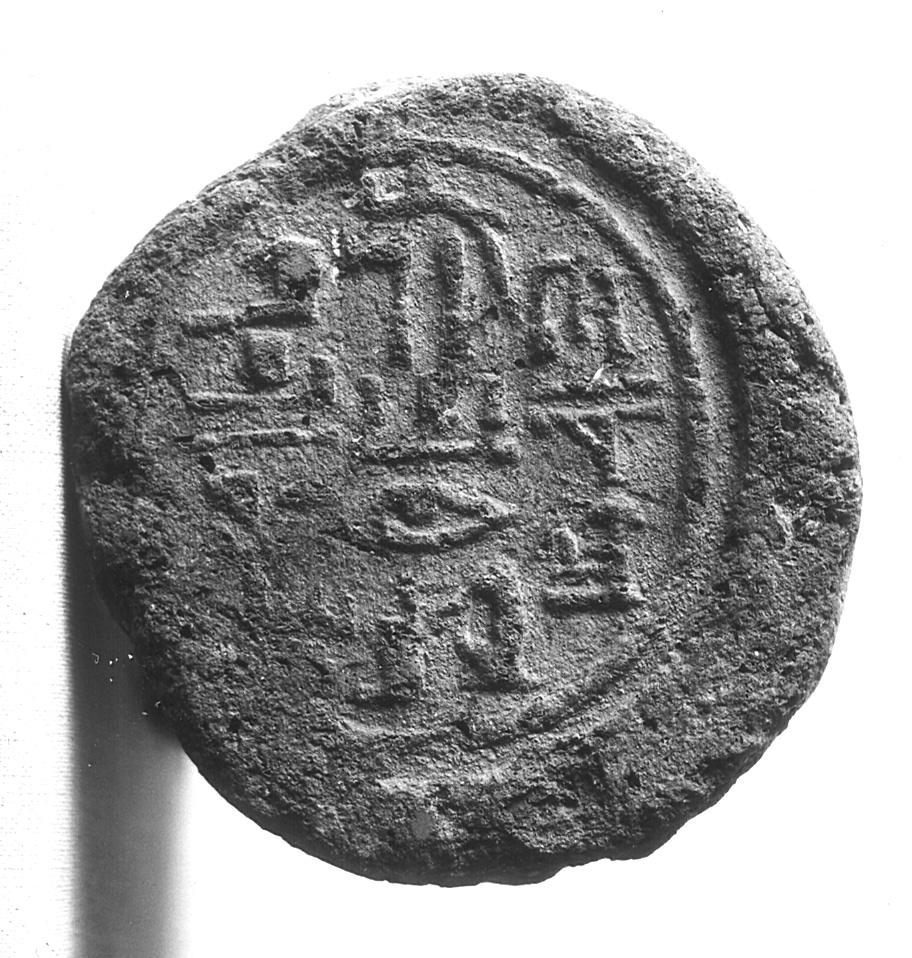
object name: cone, circular impression, min, scribe, overseer, priest, osiris, oasis, tt 109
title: Funerary Cone of Min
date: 1479-1425 BCE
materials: pottery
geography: egypt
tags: hieroglyphs